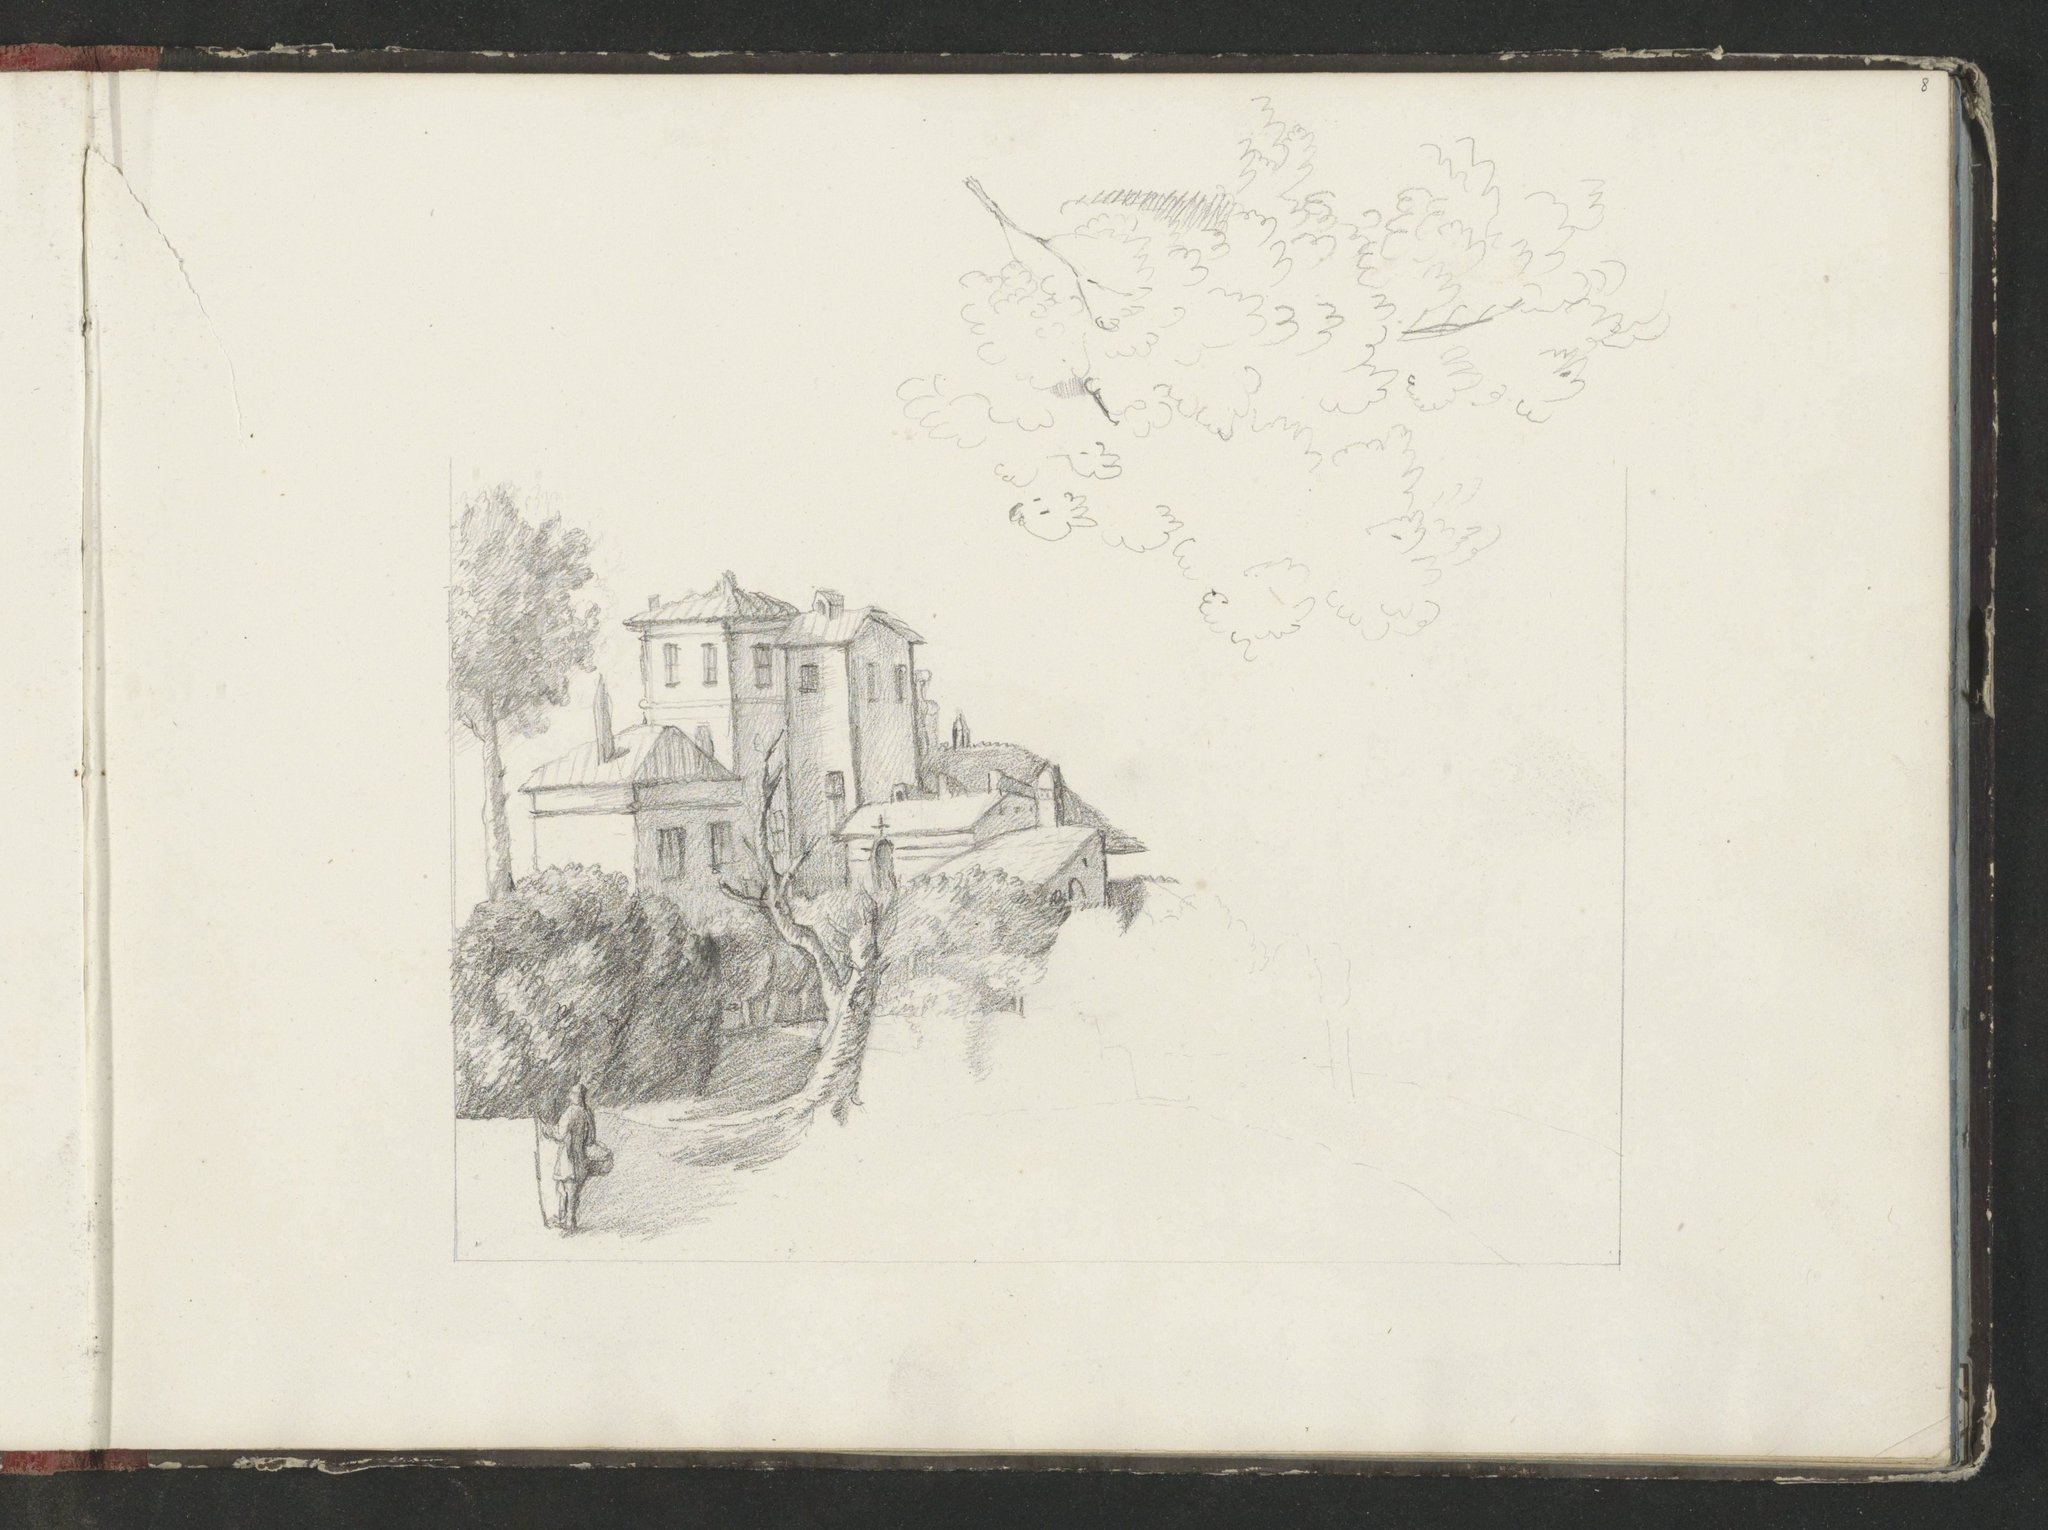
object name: sketchbook leaf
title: Wandelaar bij een villa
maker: Anonymous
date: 1819-1870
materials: paper, pencil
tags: trees (+ branch, stick), 'en route', traveller under way, country-house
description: Een man met wandelstok en mand staat voor een villa. Tekening in een kader. Tevens een studie van een boomtak met bladeren. Blad 8 recto uit een schetsboek met 39 bladen.